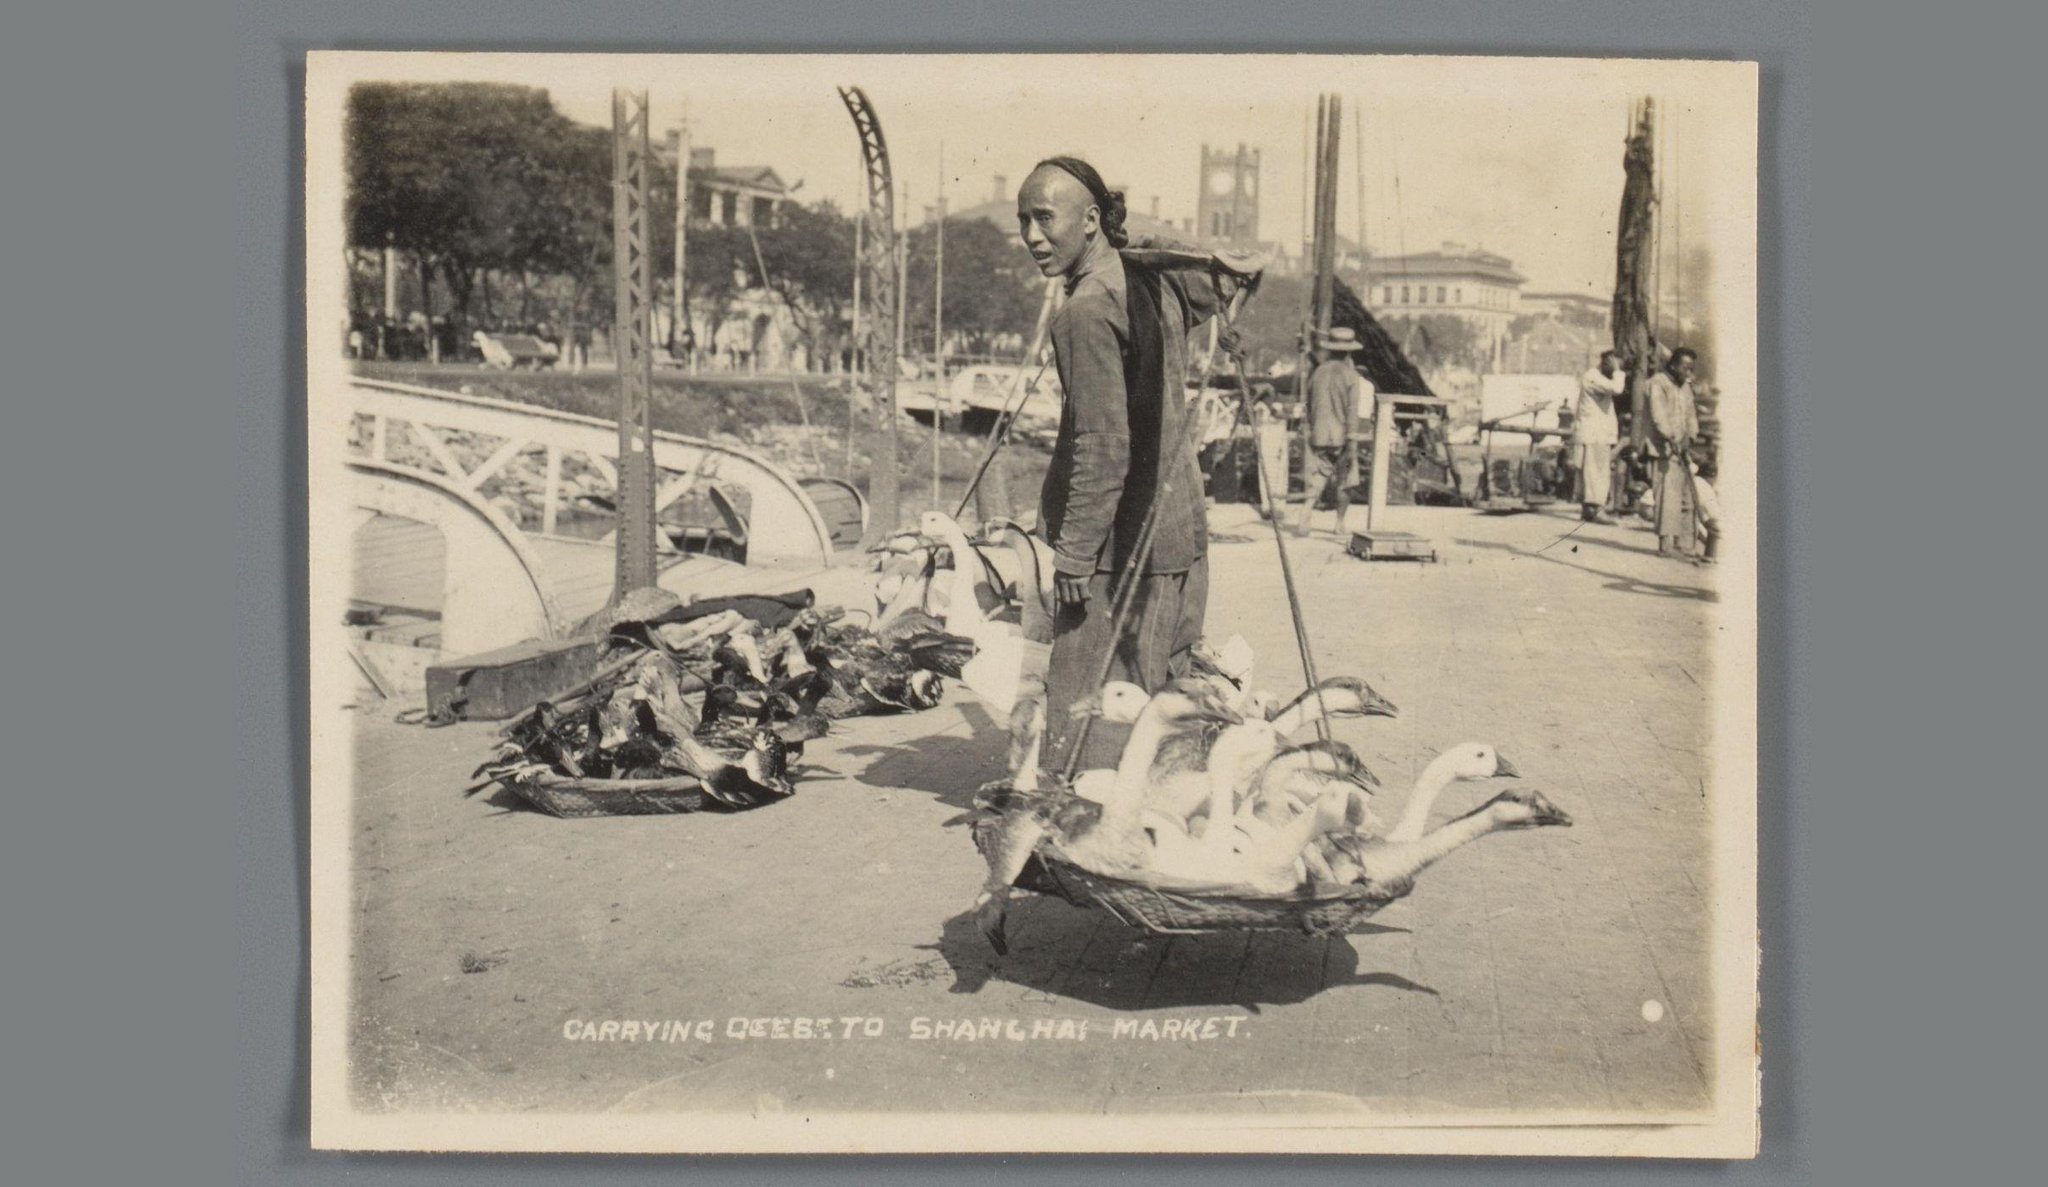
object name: photograph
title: Man brengt ganzen naar de markt, Shanghai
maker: Anonymous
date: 1910-1930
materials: paper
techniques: gelatin silver print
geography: shanghai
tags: going to the market, geese (domestic waterbirds)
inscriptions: stamp: ‘Copyright Photograph by Mactavish & Co., Ltd./ Shanghai.’